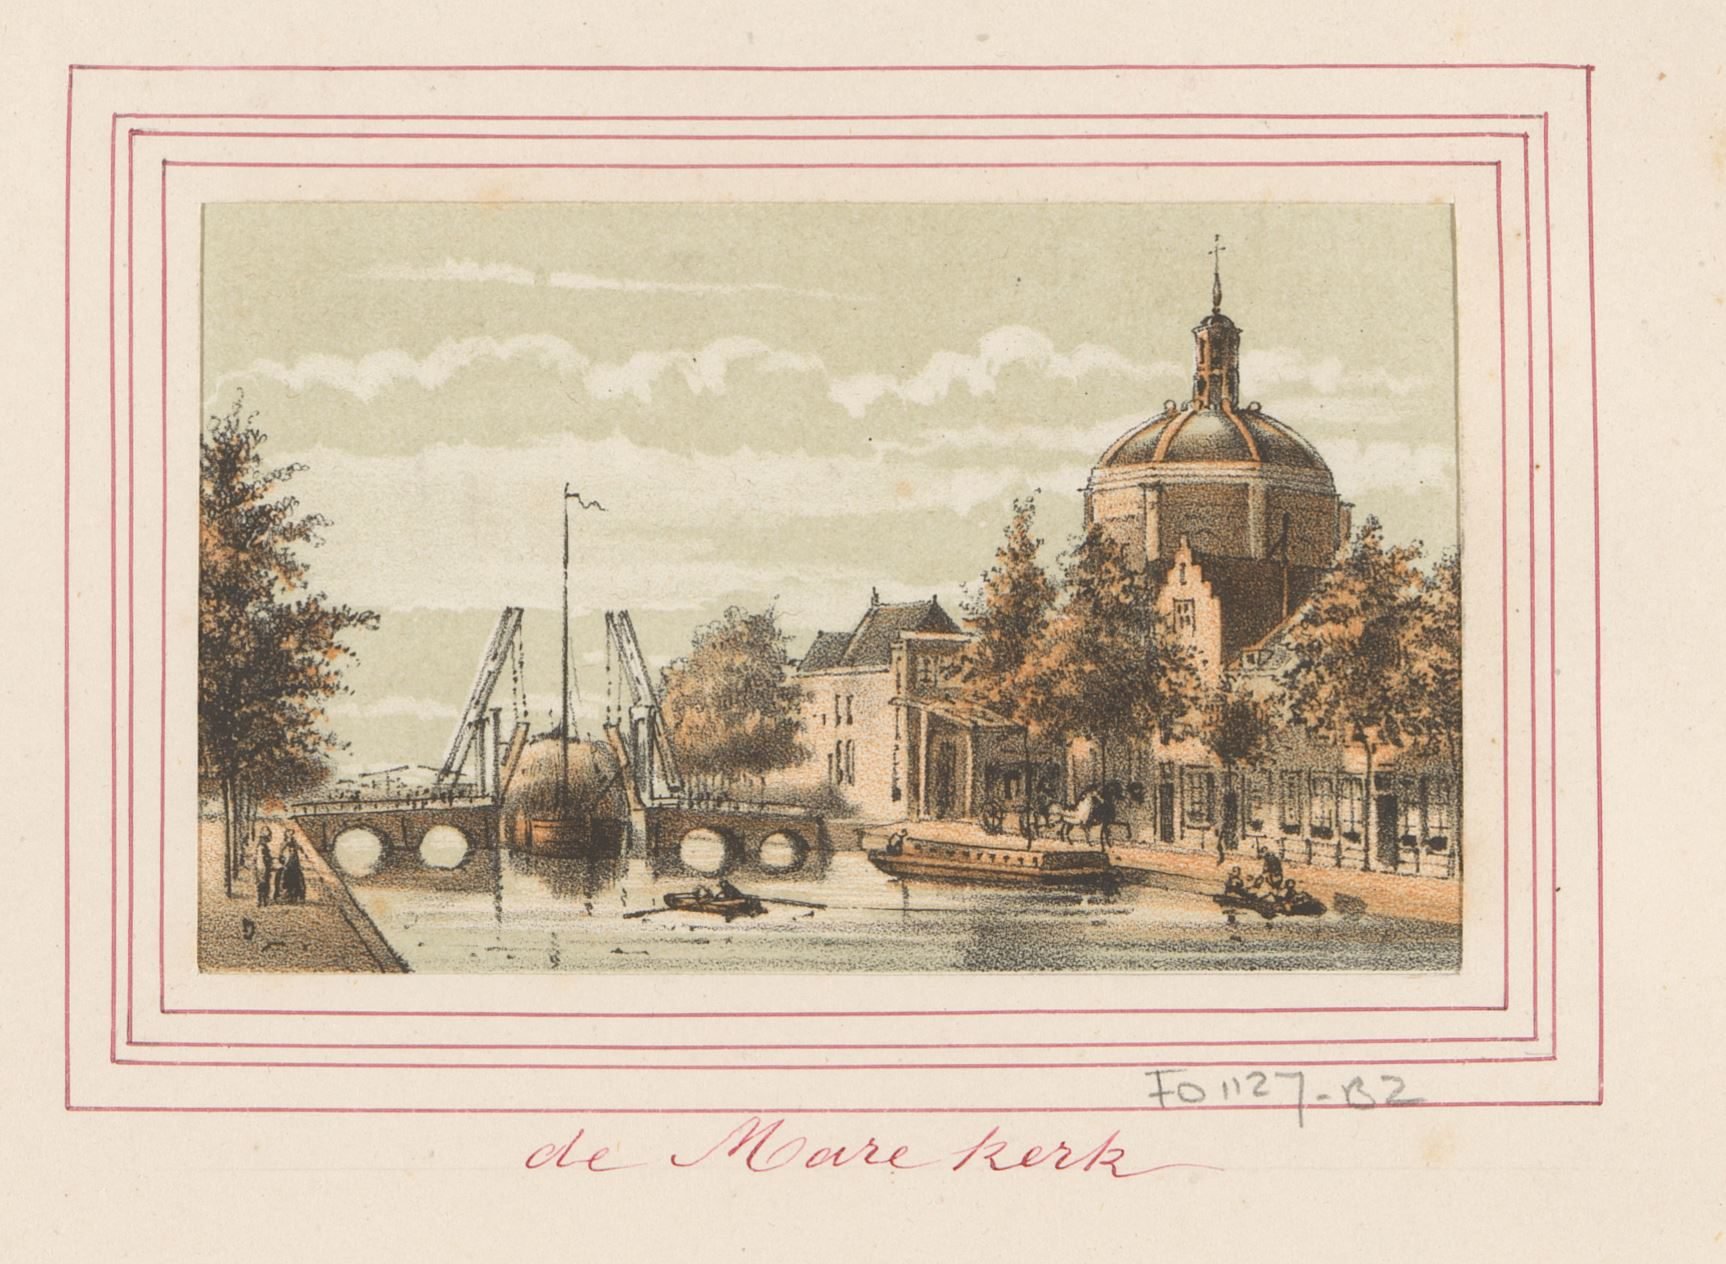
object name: print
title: Mare in Leiden met rechts de Marekerk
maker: Anonymous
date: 1865-1875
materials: paper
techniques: tone lithography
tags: church (exterior), bridge in city across river, canal, etc.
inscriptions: inscription: ‘de Mare kerk’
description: Onderdeel van album met foto's en litho's van bezienswaardigheden in Noord- en Zuid-Hollandse steden, schilderijen en klederdrachten.